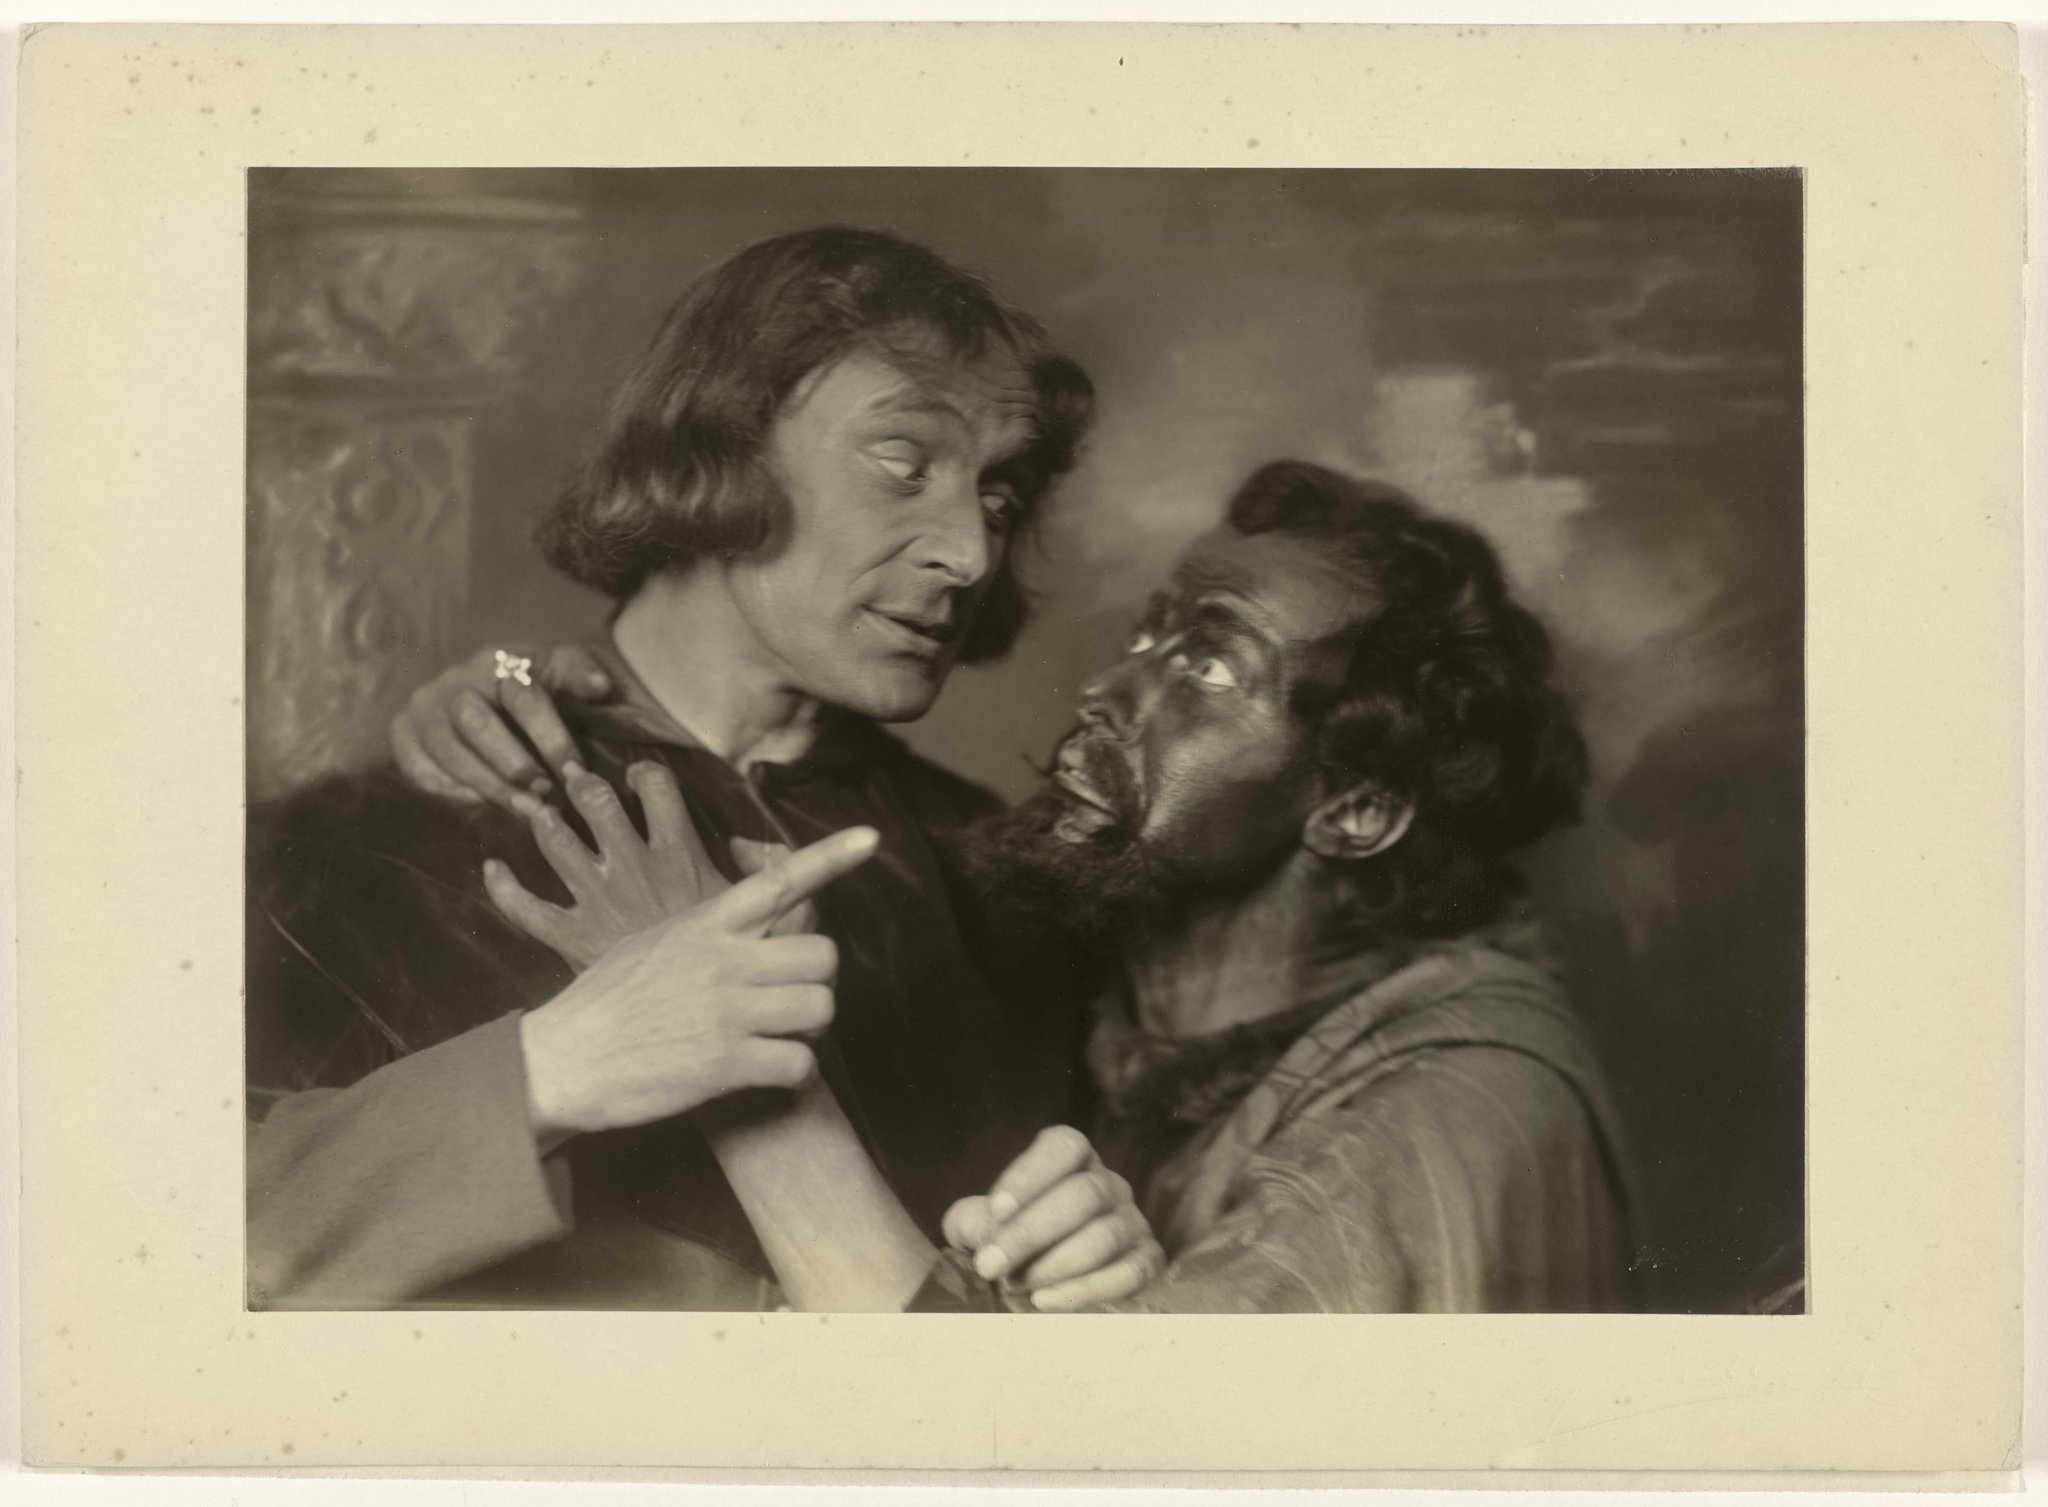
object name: photograph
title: Van Walsum en Koen Kooy in toneelstuk Othello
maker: jacob merkelbach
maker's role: fotograaf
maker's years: 1877-1942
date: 1925-1930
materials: cardboard, photographic support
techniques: gelatin silver print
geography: amsterdam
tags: portrait of actor, actress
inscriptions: check stamp: ‘J. Merkelbach amsterdam’, inscription: ‘... van Walsum Koen Kooy (Othello)’